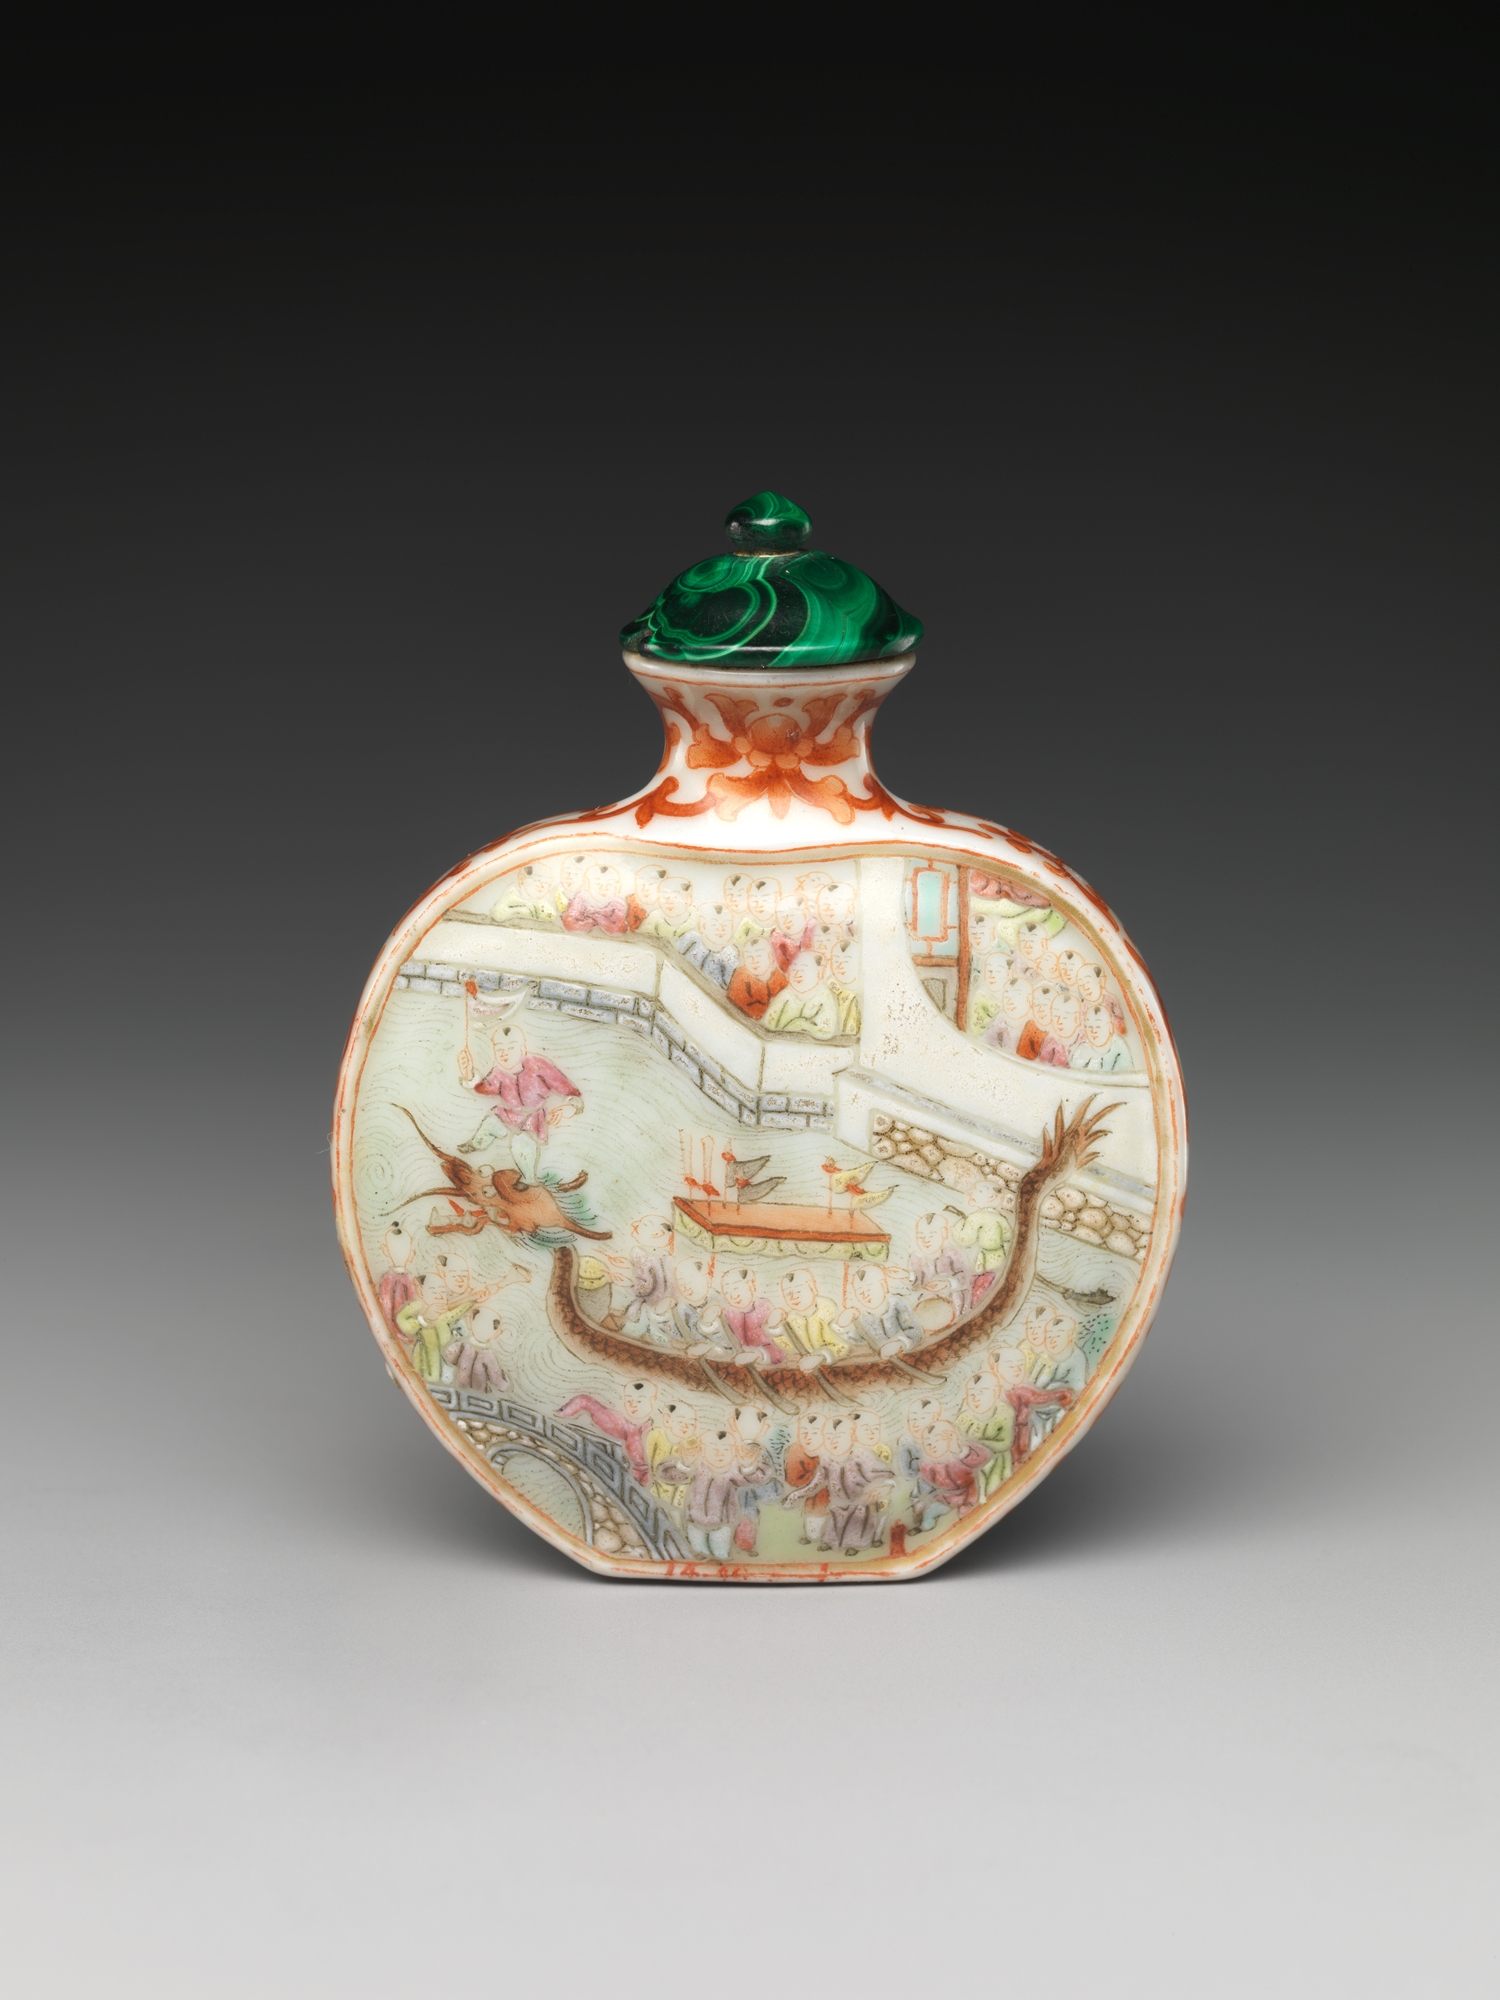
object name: snuff bottle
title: Snuff Bottle with Scene of Dragon-Boat Festival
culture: chinese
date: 1796-1820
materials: enamel, porcelain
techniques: overglaze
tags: human figures,spectators,dragons,boats